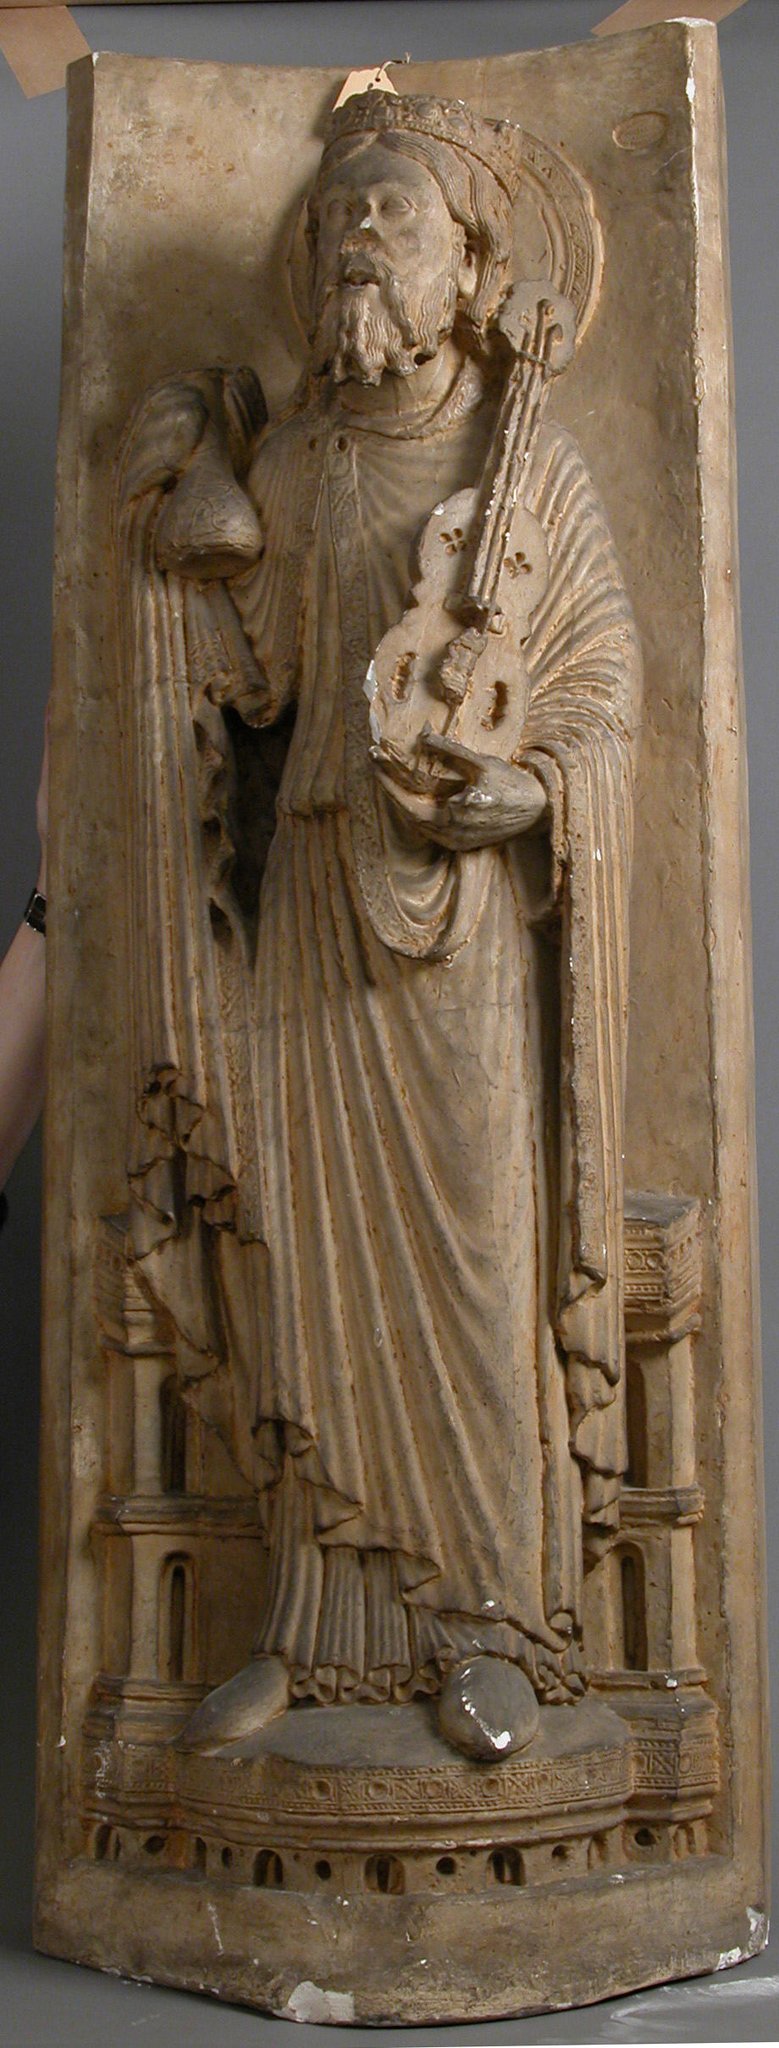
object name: elder of the apocalypse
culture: french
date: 1145-1155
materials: plaster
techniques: casting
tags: men,violins,apocalypse